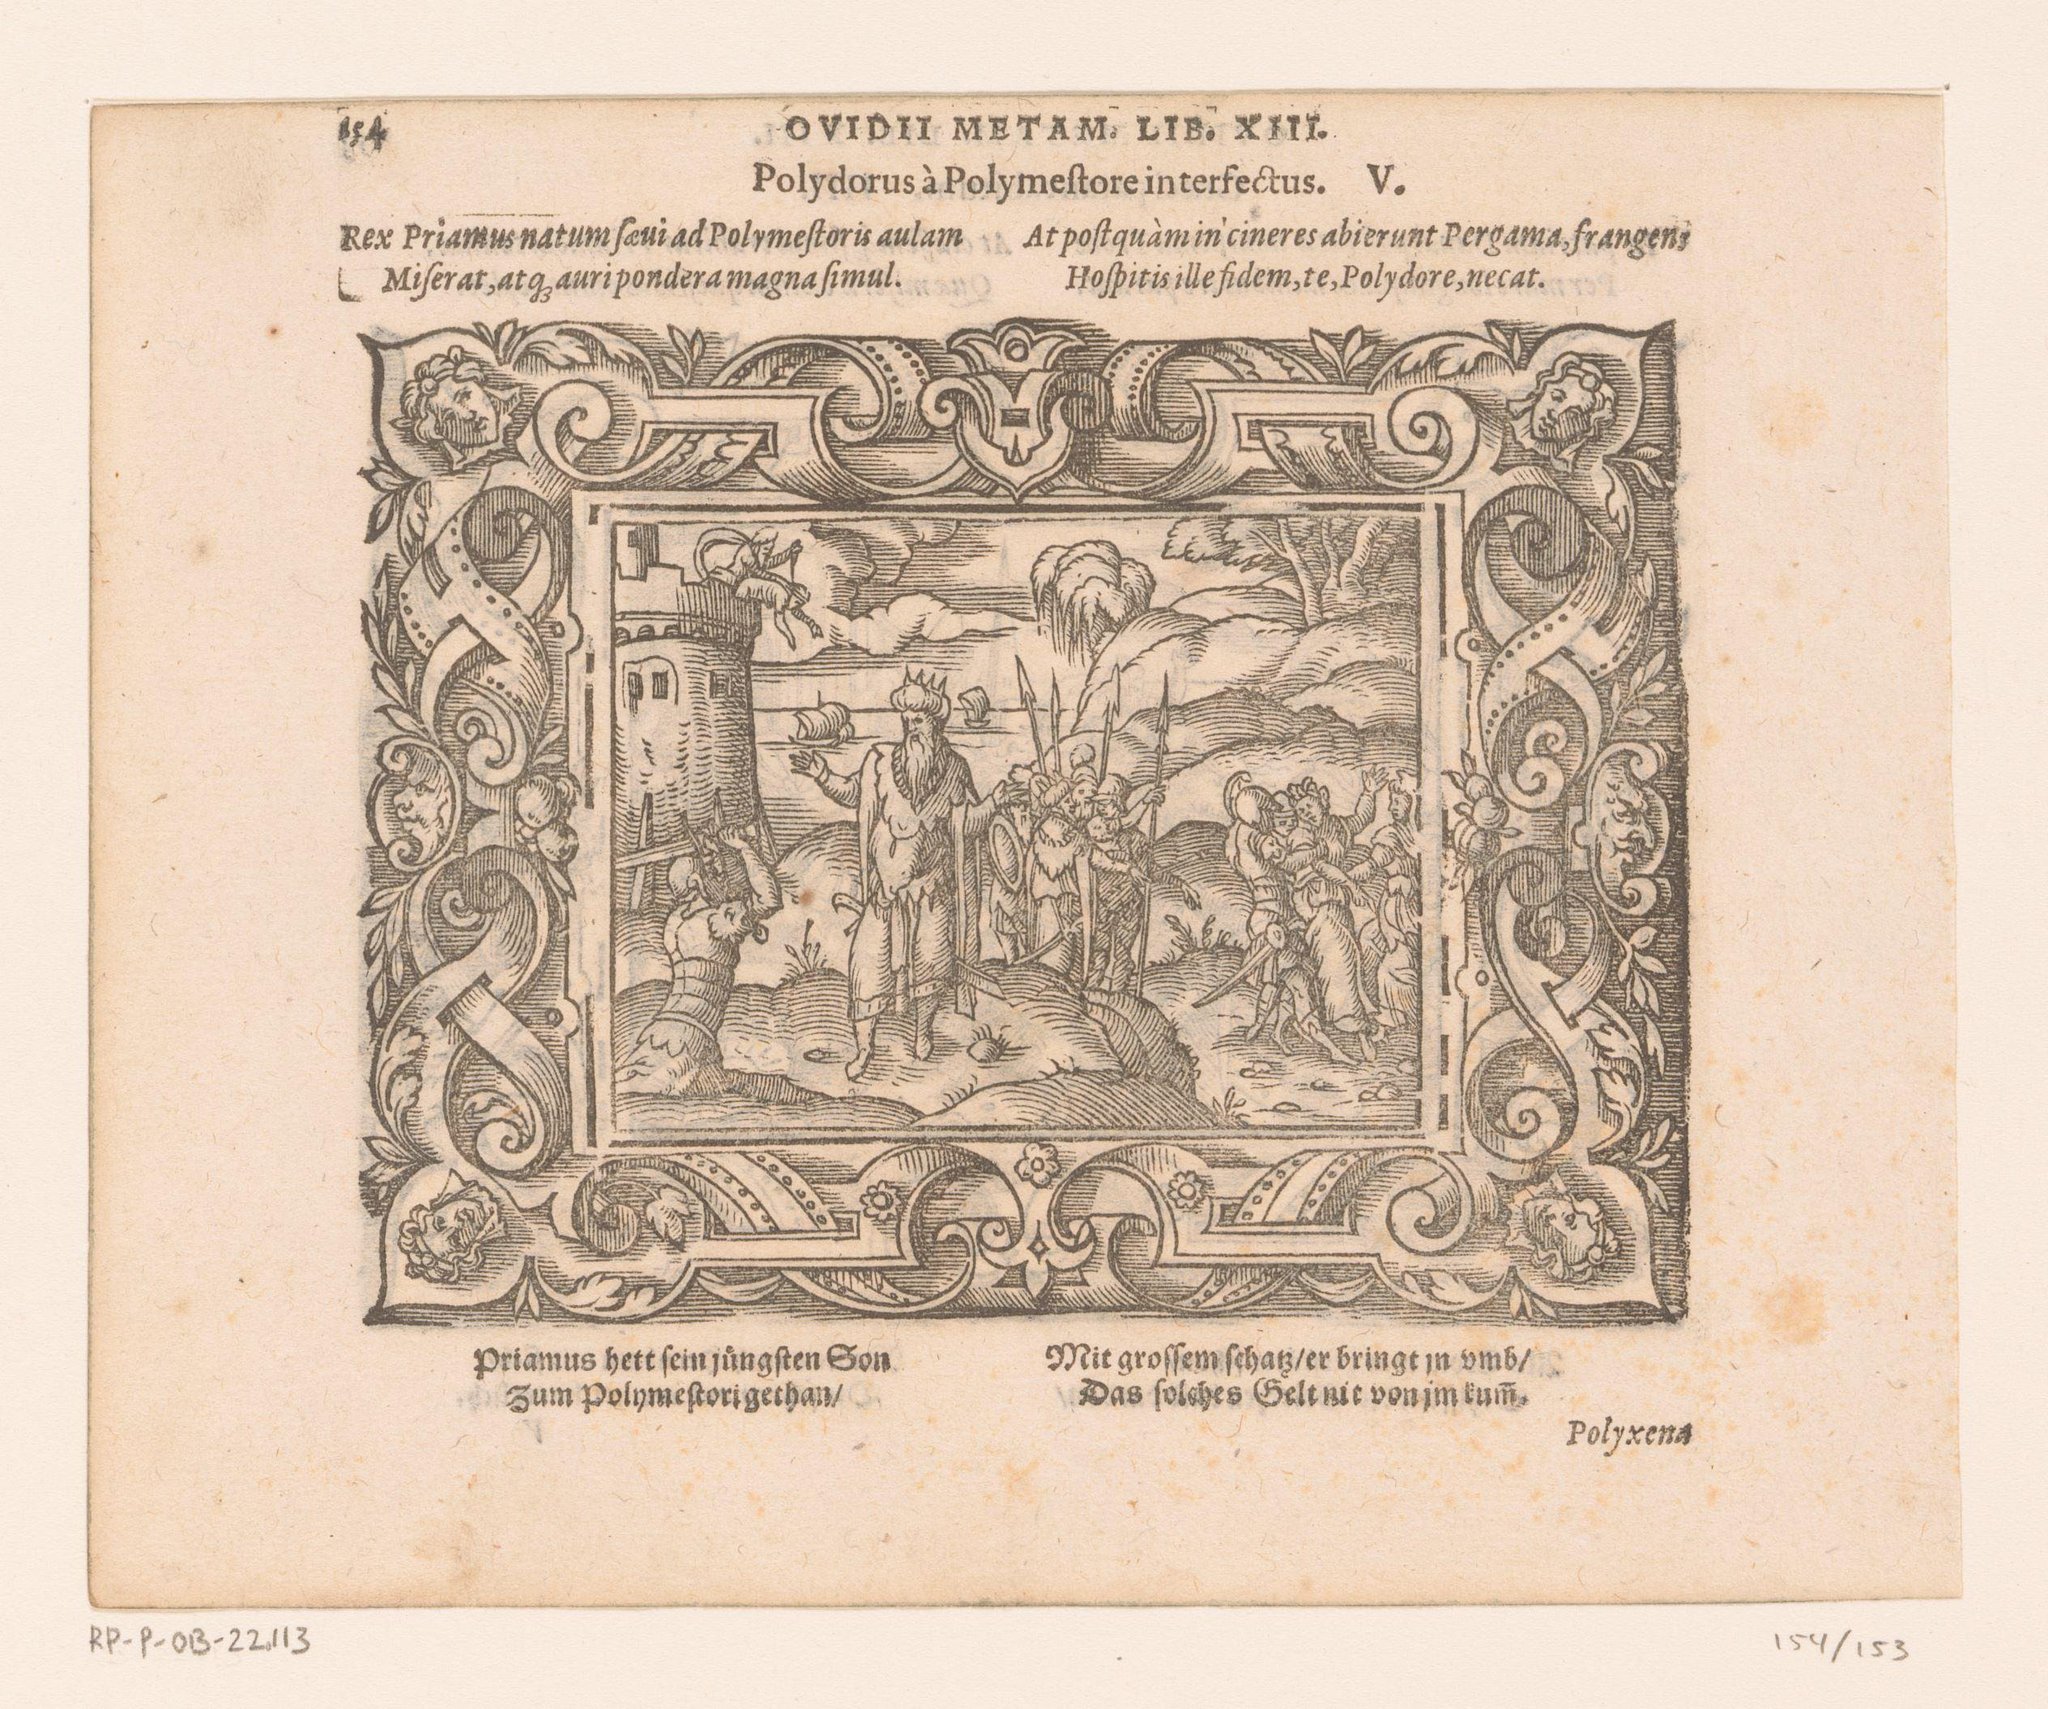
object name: print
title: Polydorus à Polymestore interfectus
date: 1569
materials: paper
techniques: letterpress printing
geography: frankfurt am main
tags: hecuba is dragged away from the tomb of her sons, polymnestor kills polydorus and throws him into the water, scrollwork, strapwork ~ ornament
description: Illustratie bij de Metamorfosen van Ovidius, afkomstig uit de publicatie: Posthius, Johannes. Tetrasticha in Ovidii metam. Frankfurt am Main: Georg Rab en Sigmund Feyerabend en erven Weigand Han, 1569. De voorstellingen en ornamentranden van deze boekillustraties zijn van twee aparte blokken gedrukt. Beide werden afzonderlijk van elkaar ook gebruikt voor andere publicaties, en de ornamentranden werden eveneens binnen deze publicatie meerdere keren gebruikt.